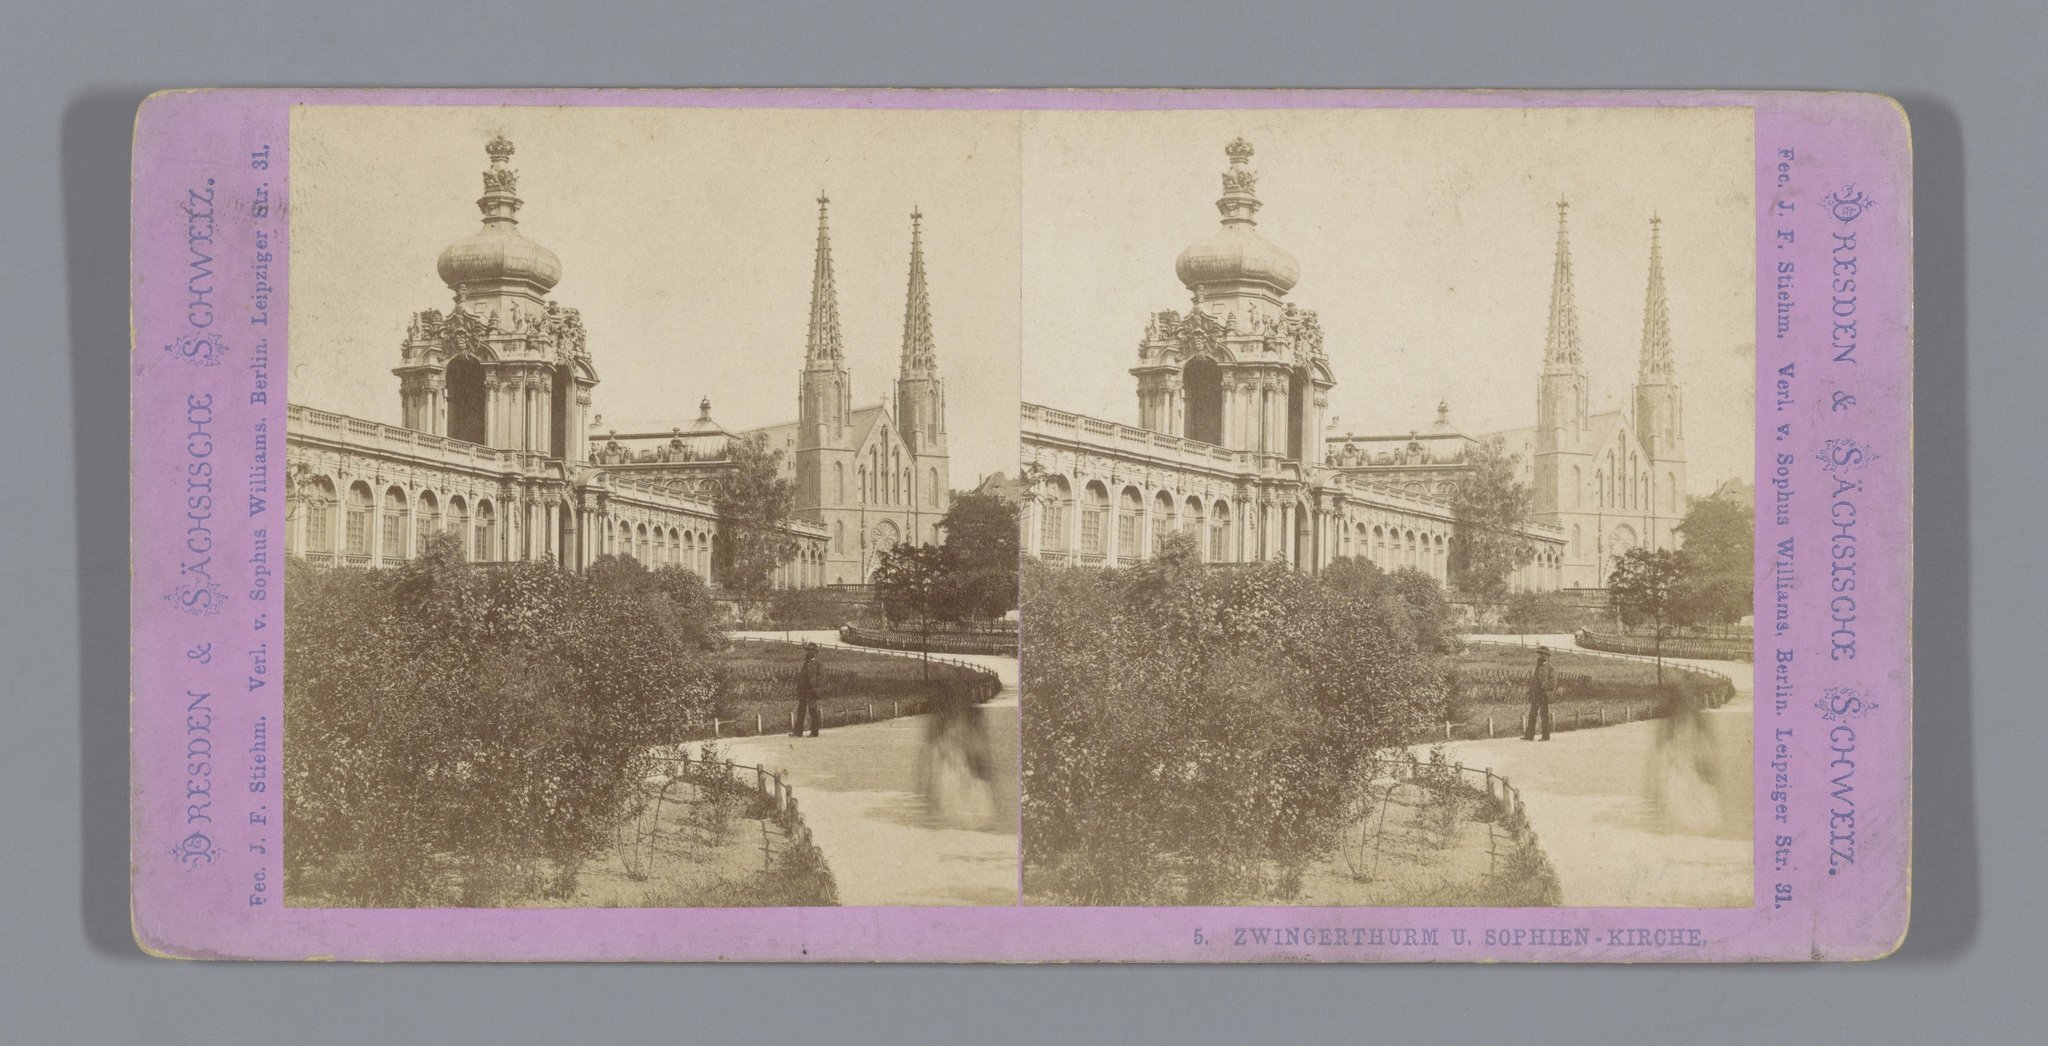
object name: stereograph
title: Dresden & Sächs. Schweiz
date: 1878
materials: cardboard, paper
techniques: albumen print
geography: dresden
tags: palace, church (exterior), tower (of house or building)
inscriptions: address: ‘Leipziger Str. 31.’, number: ‘5.’